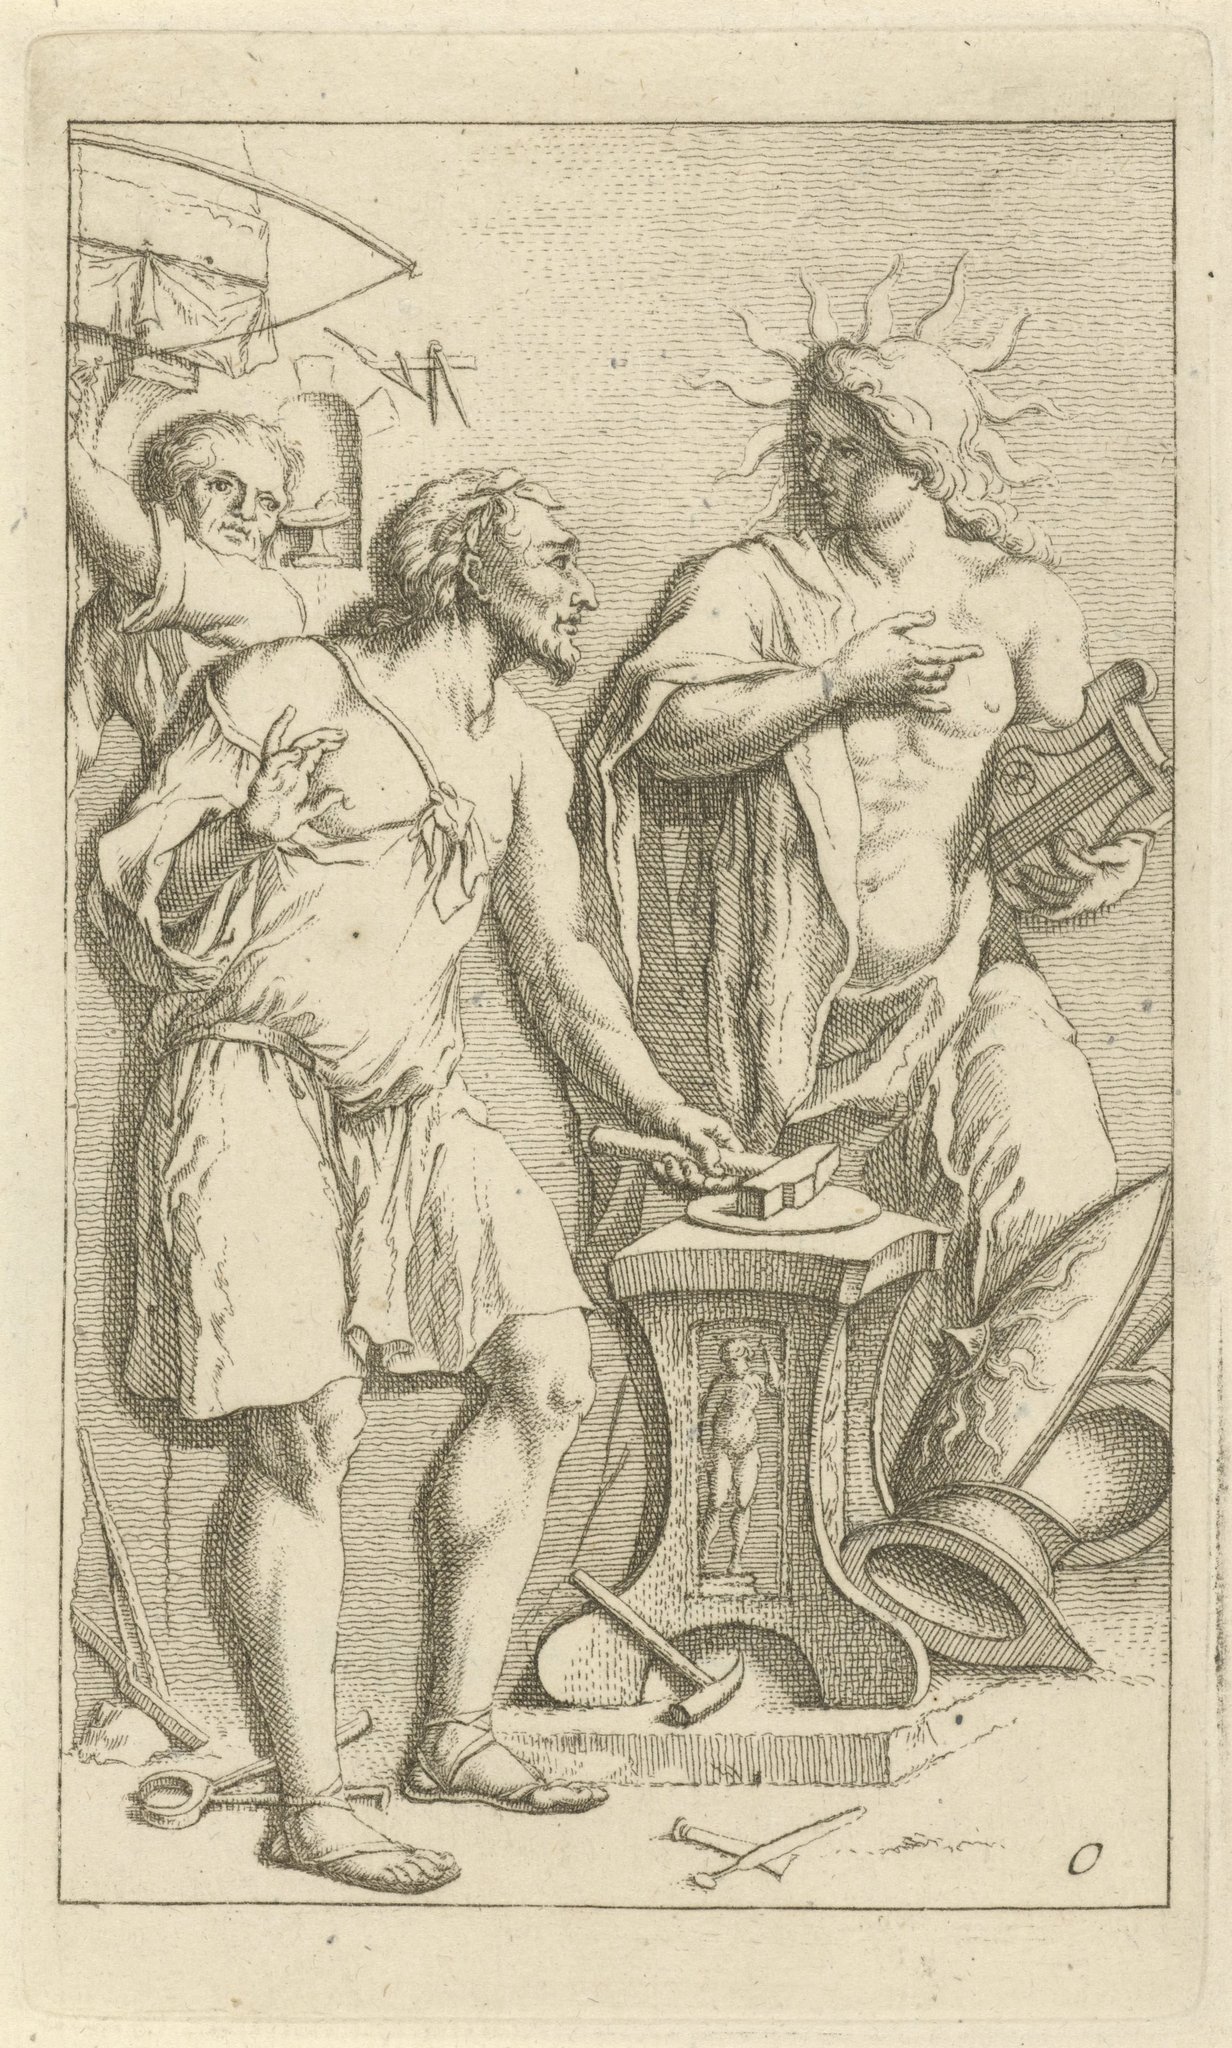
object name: print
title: Toneel van sinnebeelden geopent tot dienst van schilders beelthouders etc.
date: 1688-1700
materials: paper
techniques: etching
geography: dordrecht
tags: cupids: 'amores', 'amoretti', 'putti'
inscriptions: collector's mark: Lugt 2228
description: Vulcanus, bij zijn aambeeld, hoort geschokt het nieuws aan van Apollo, dat zijn echtgenote Venus overspel pleegt met Mars. Apollo heeft zijn lier vast en heeft een lichtkrans van zonnestralen rond het hoofd. Rechtsonder: O. Prent van deel 1 van een serie prenten met zinnebeelden, in totaal bestaande uit drie delen met respectievelijk 23, 17 en 20 prenten.